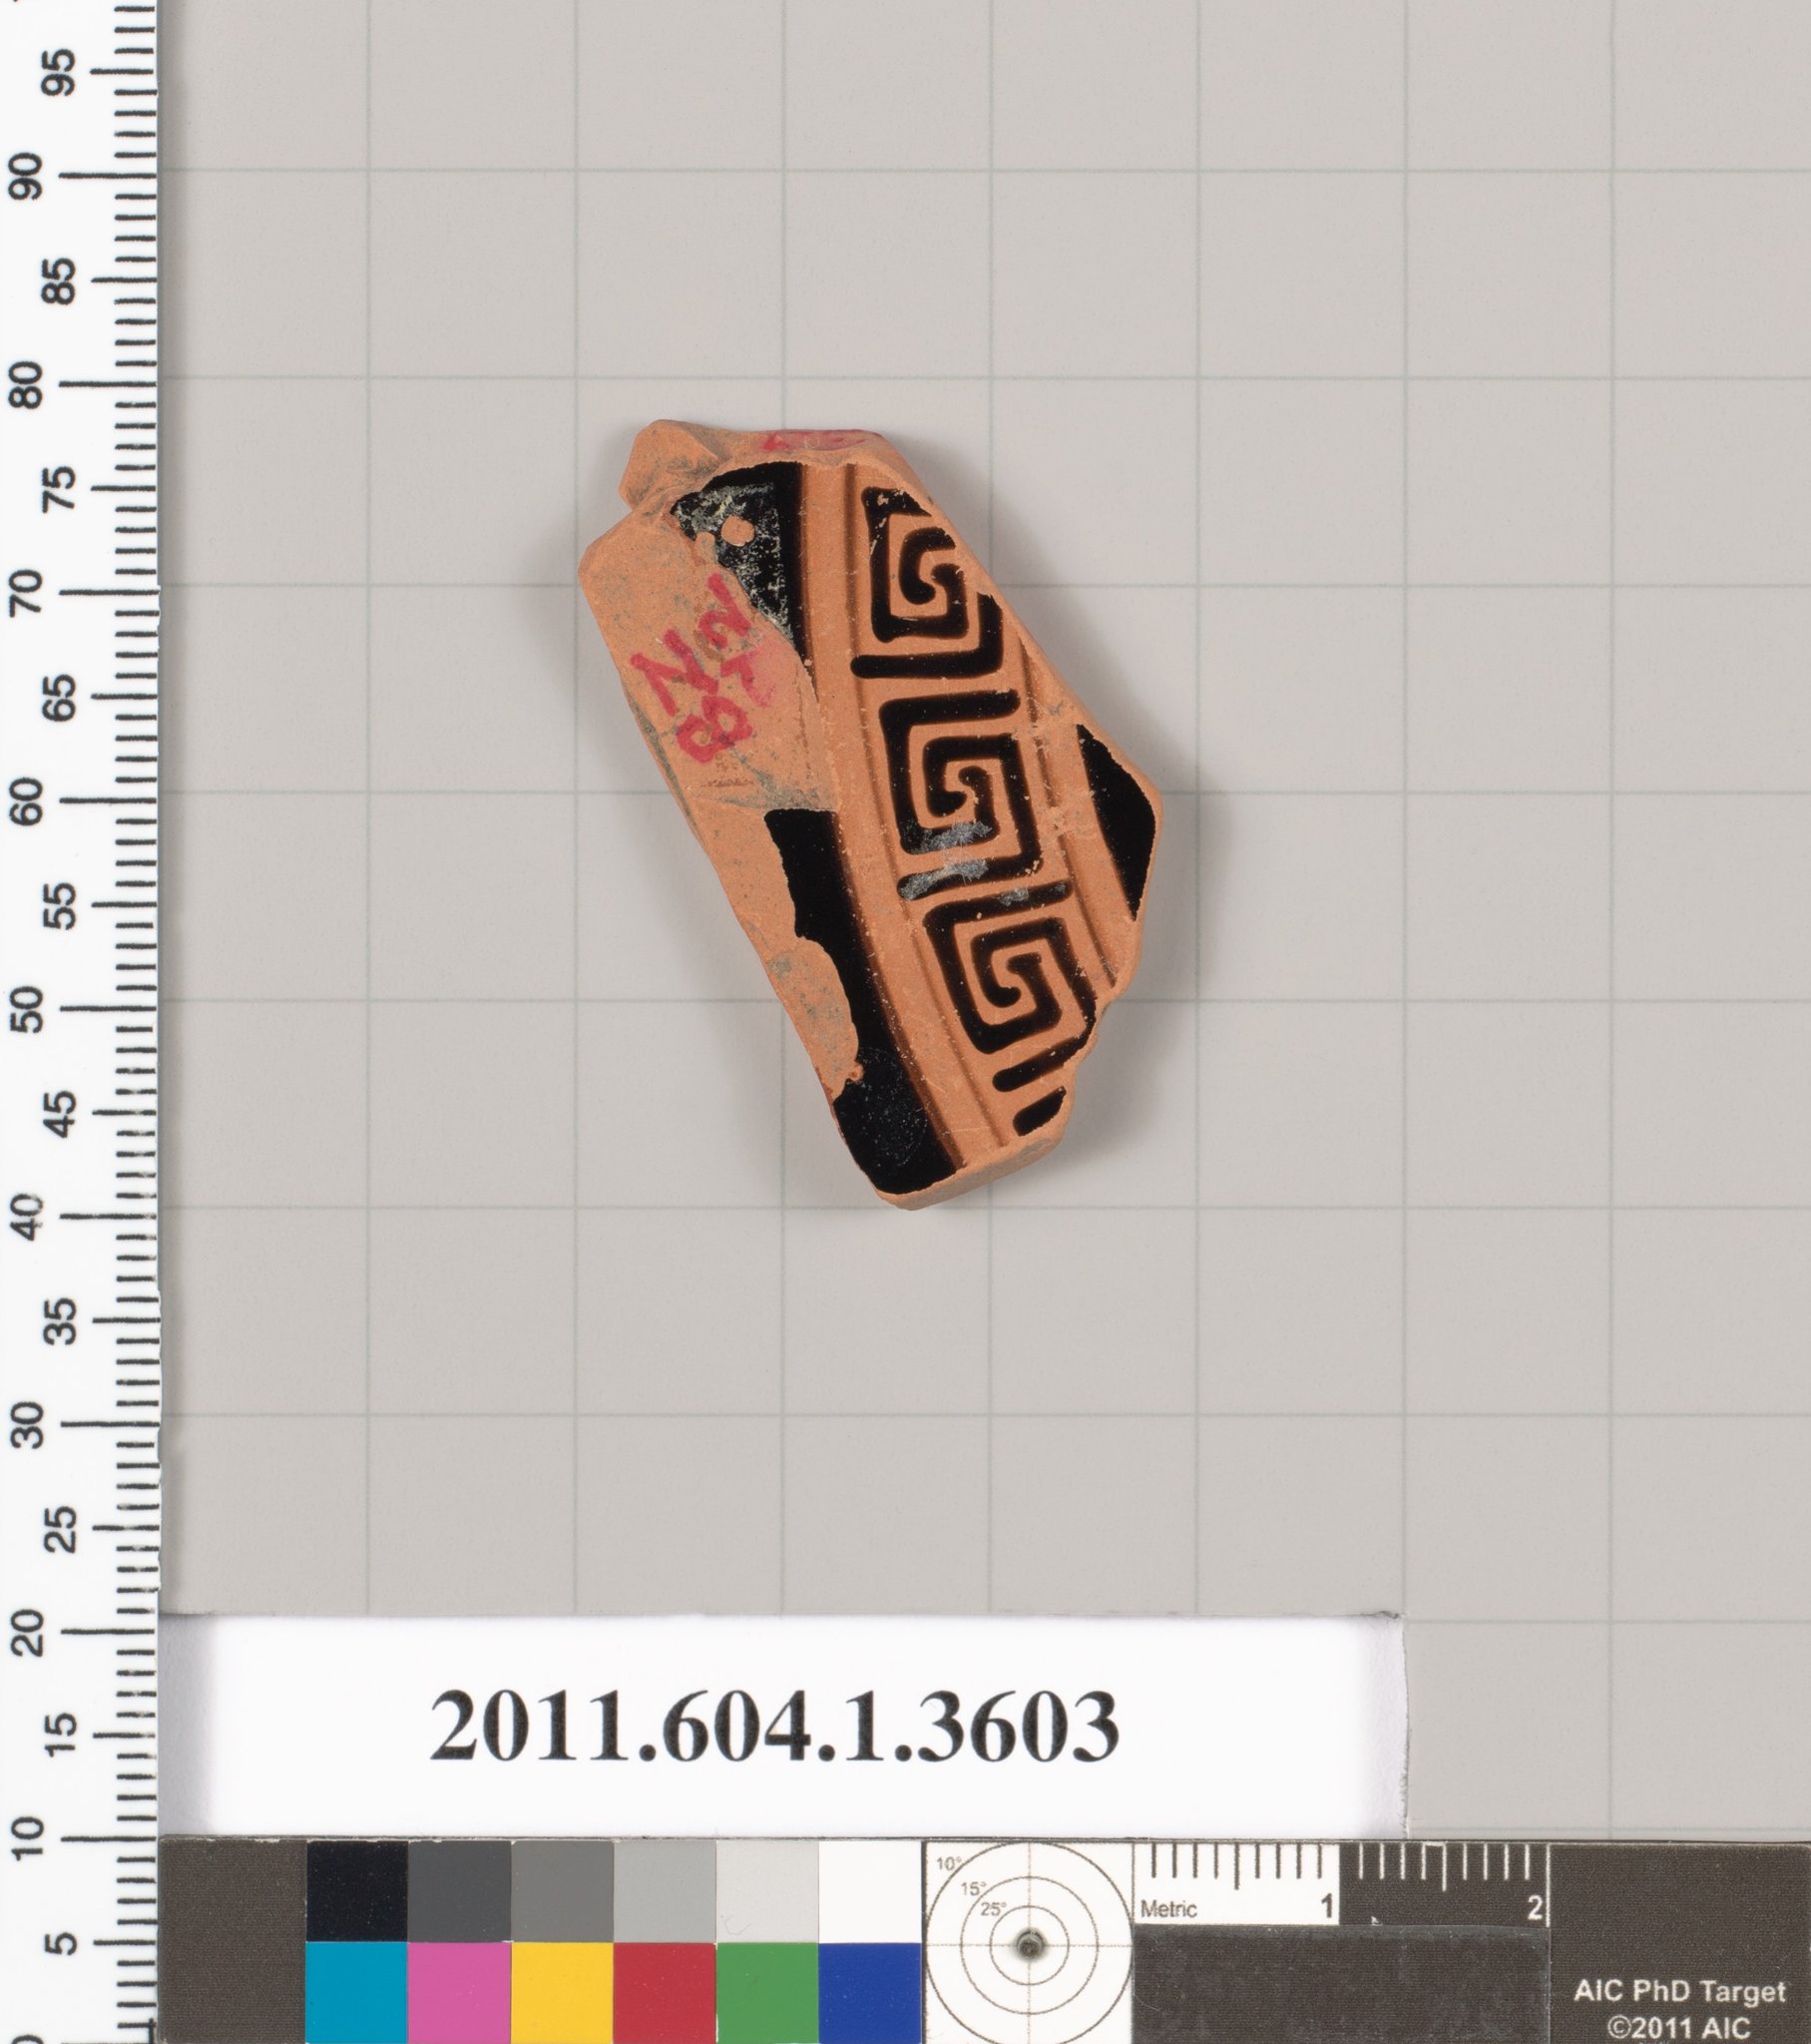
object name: kylix fragment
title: Terracotta fragment of a kylix (drinking cup)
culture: greek, attic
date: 500-480 BCE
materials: terracotta